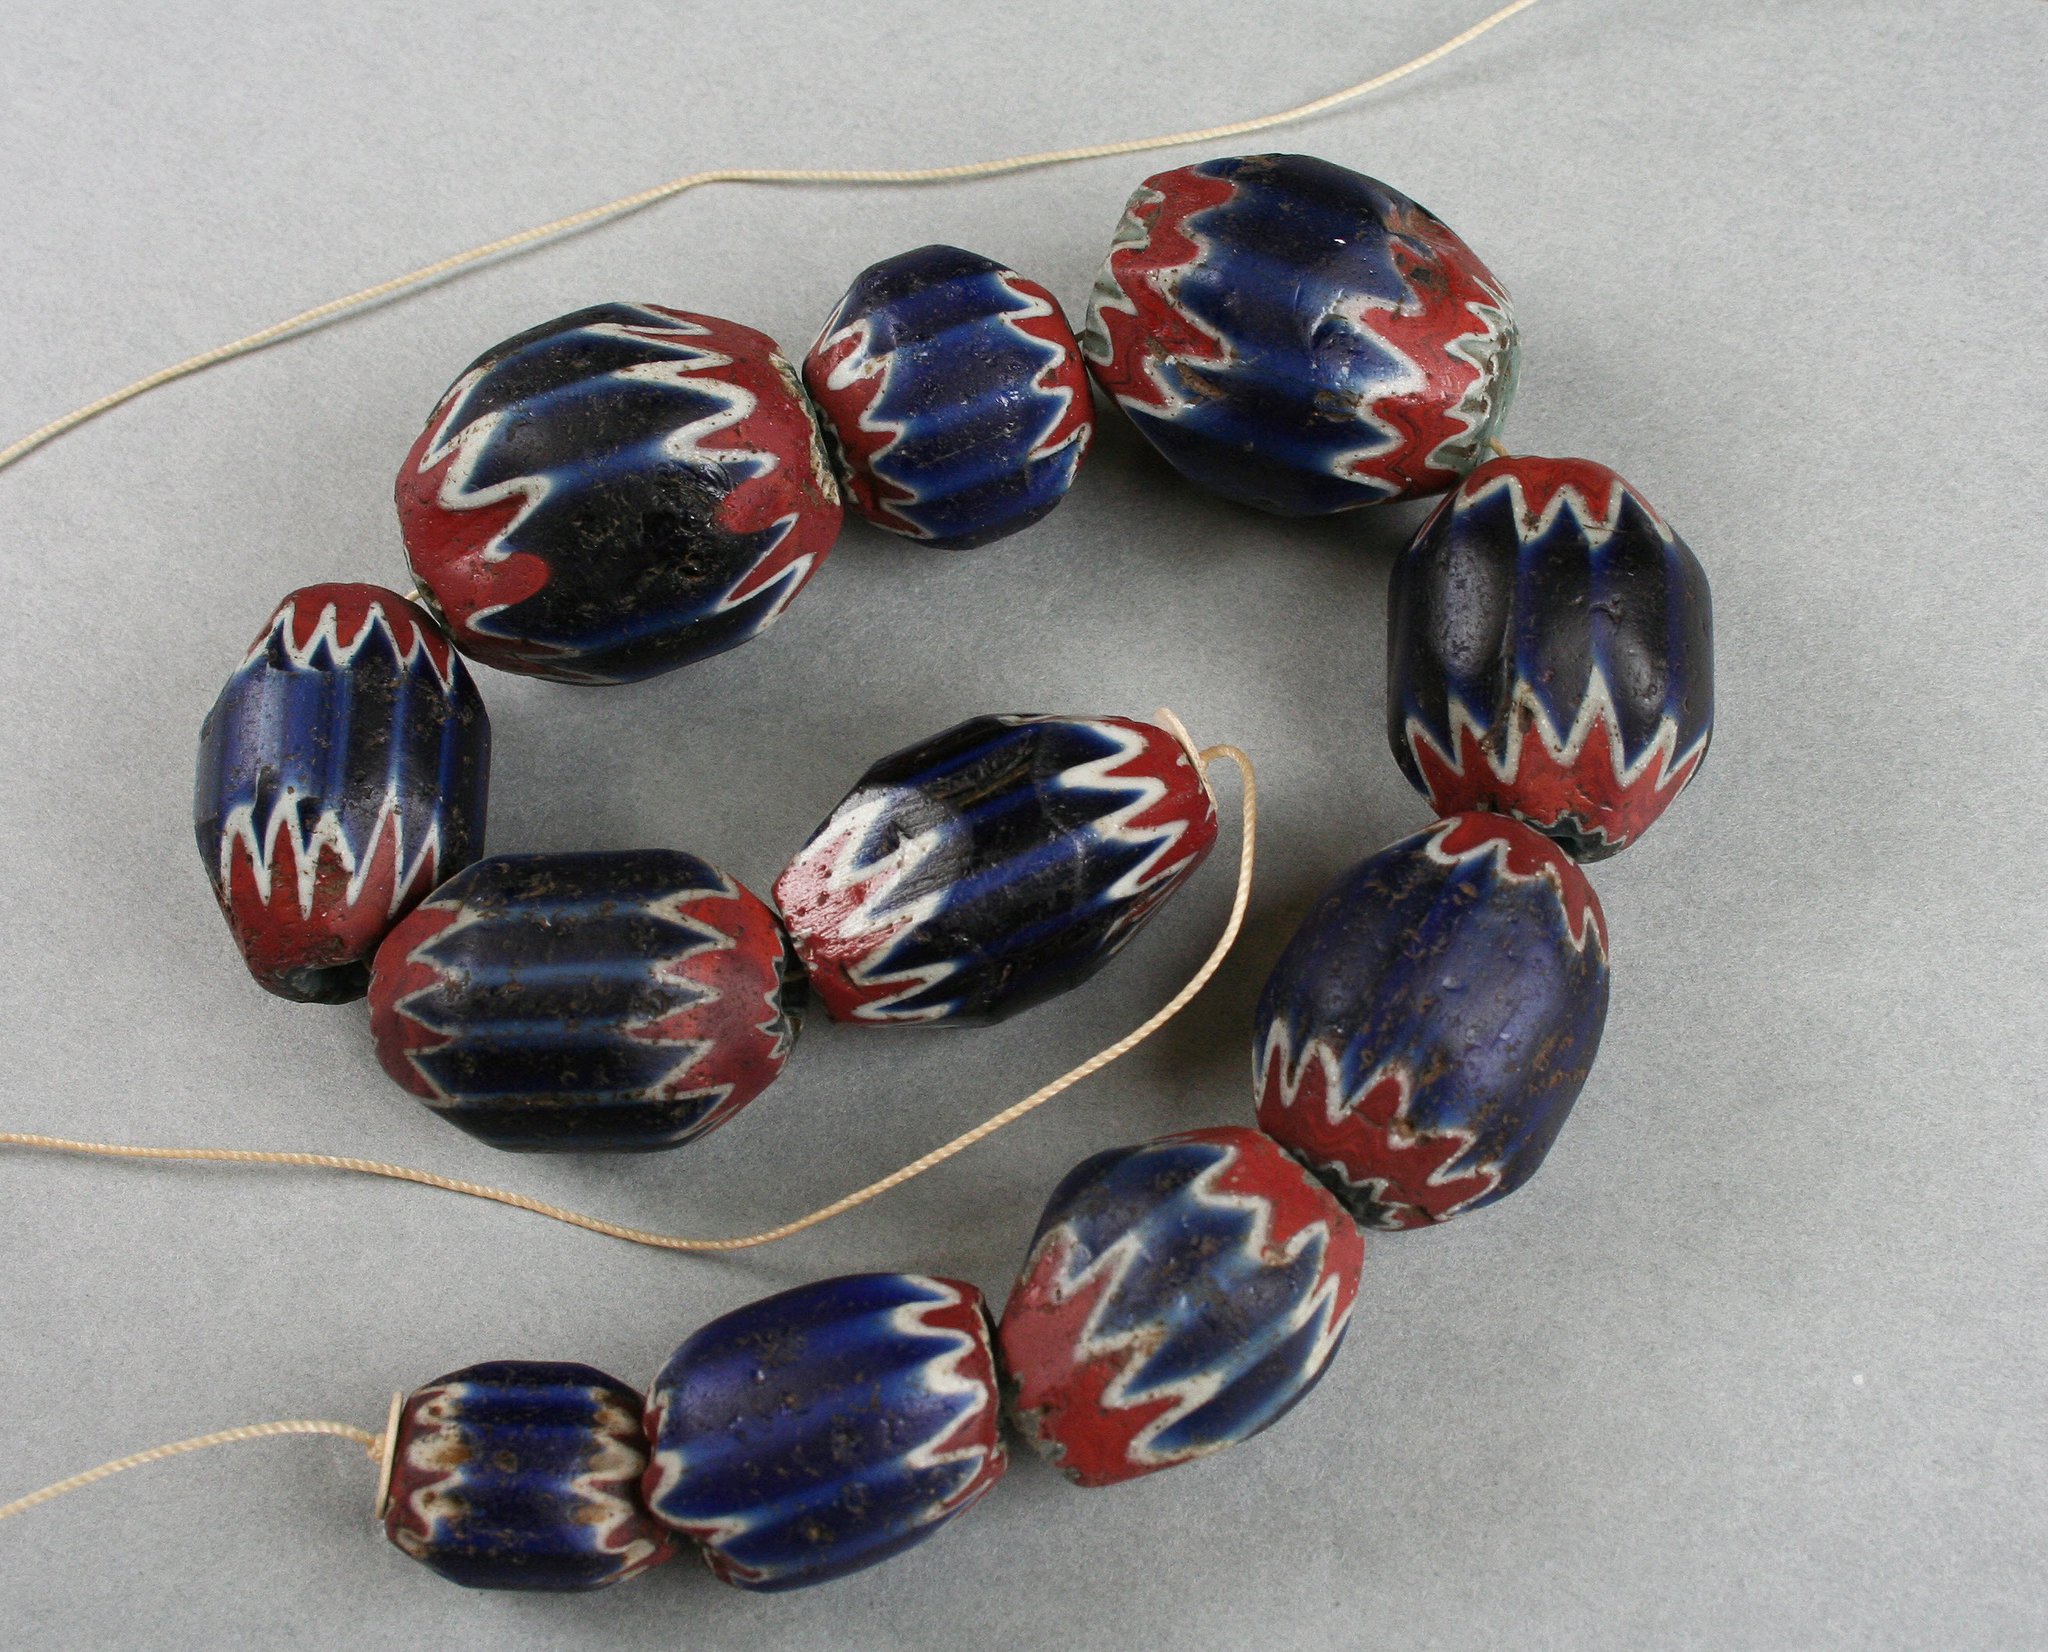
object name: bead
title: Chevron Beads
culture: african or european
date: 1701-1800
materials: glass